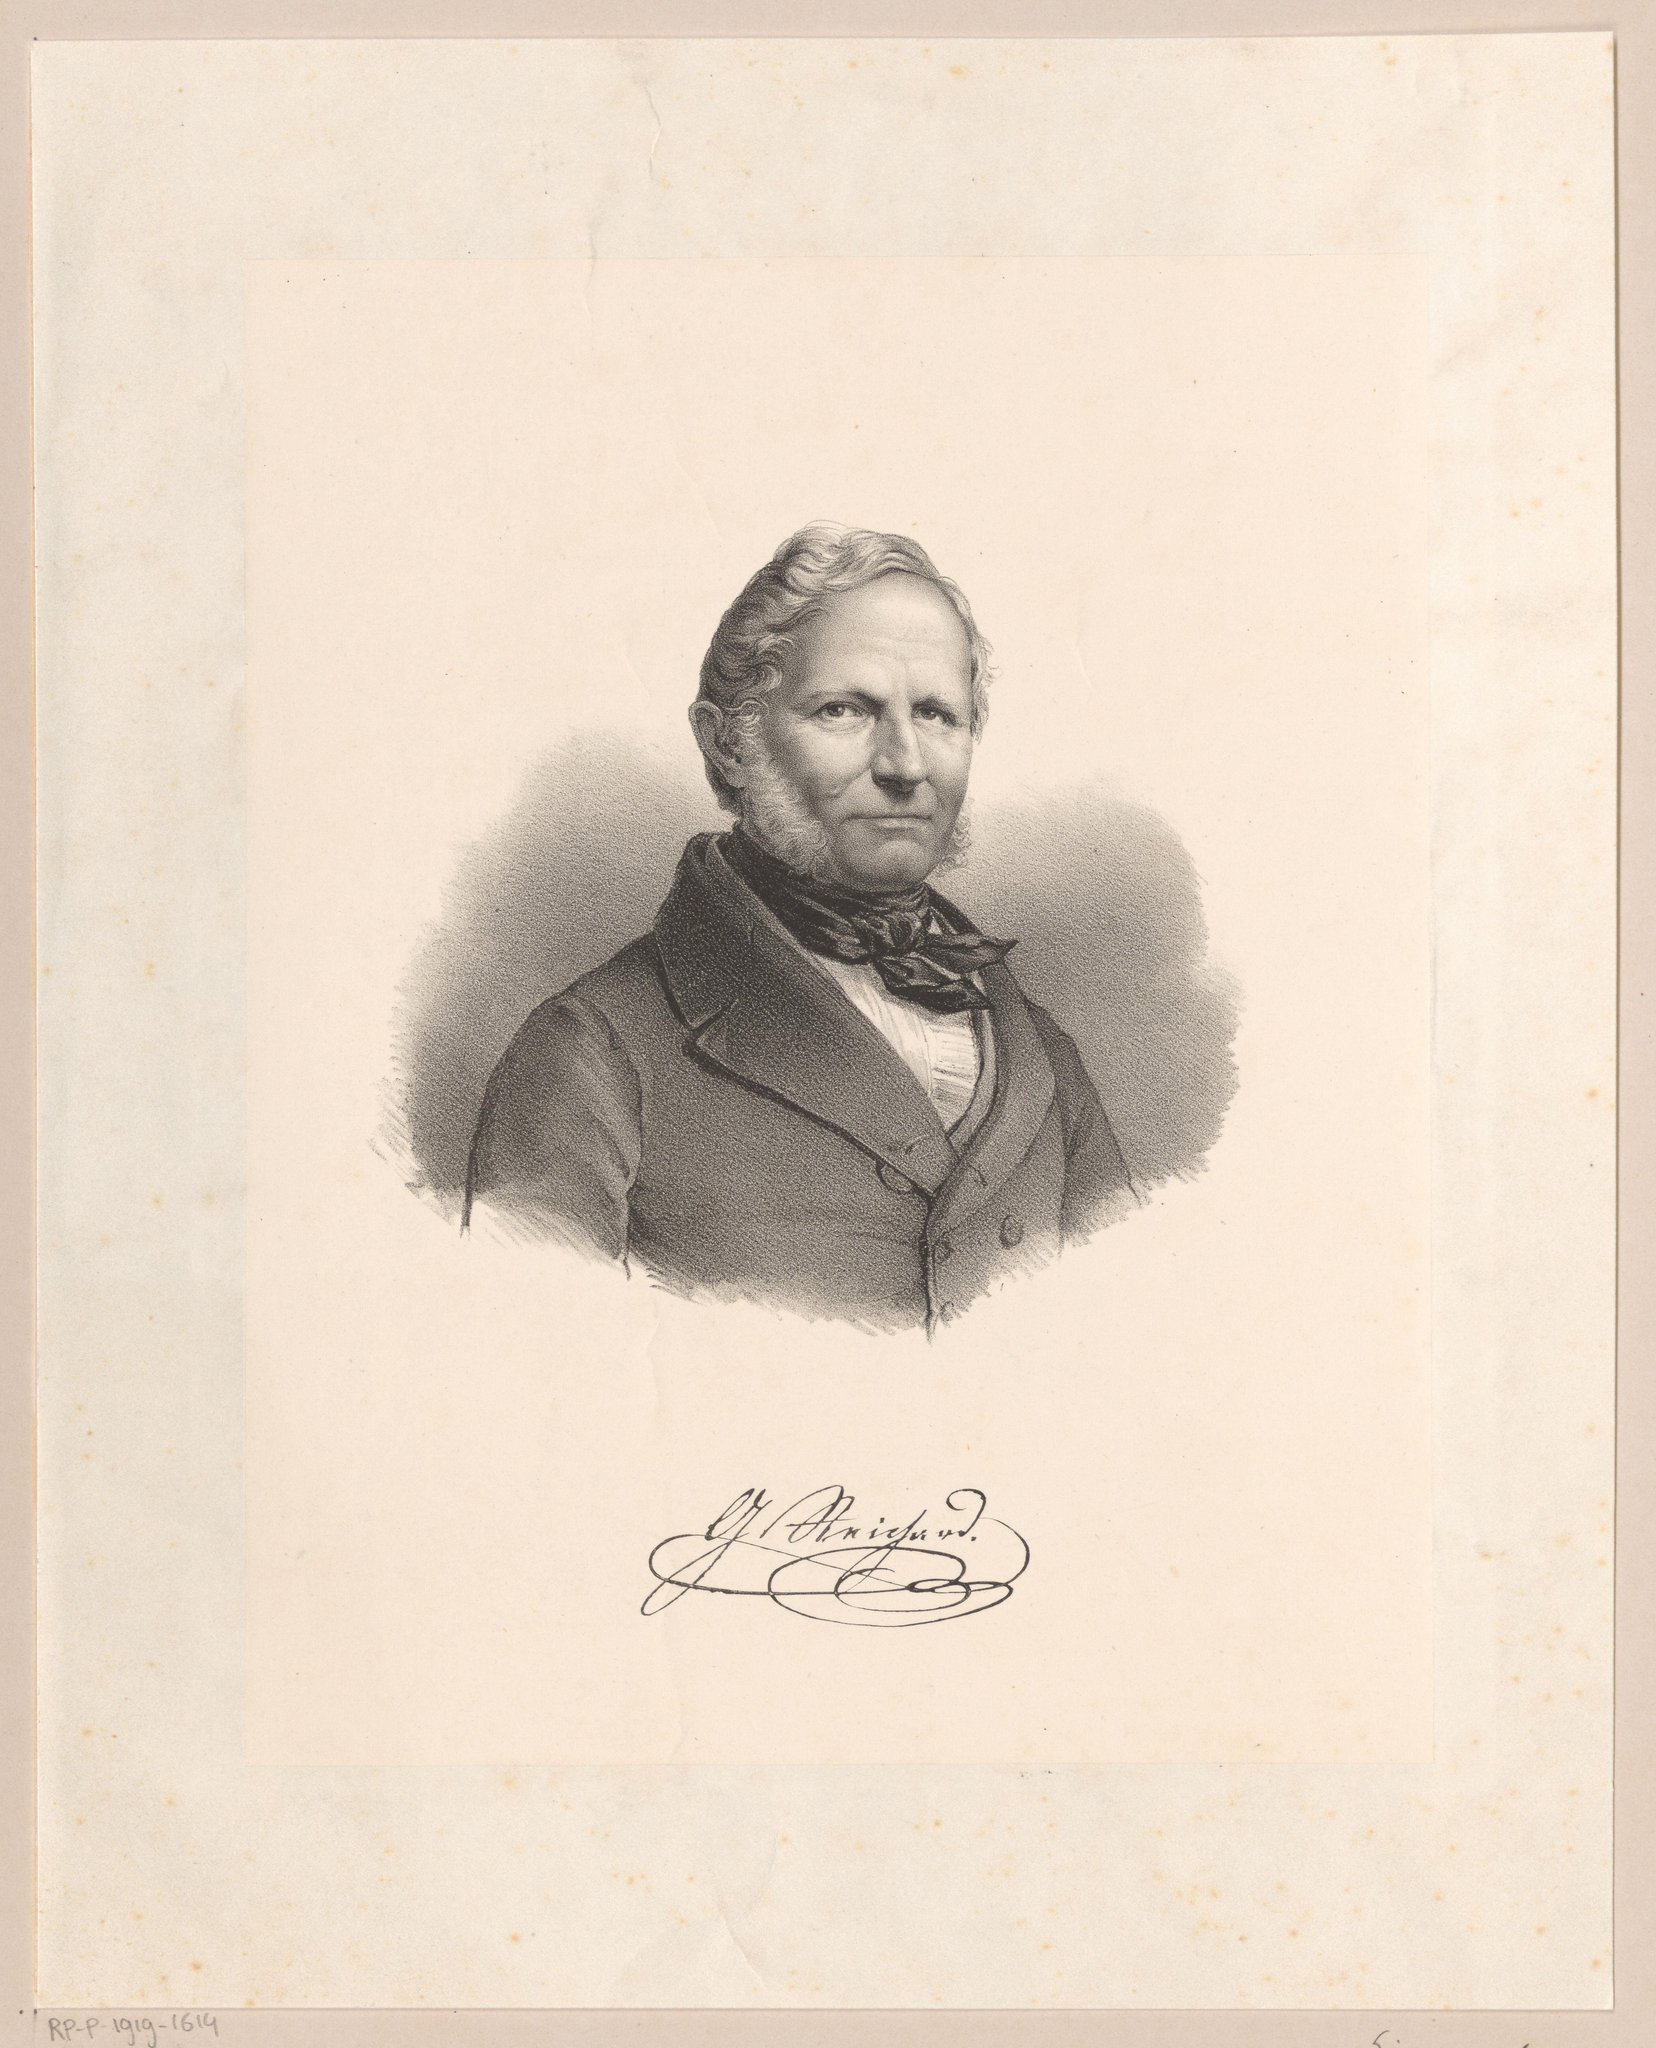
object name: print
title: Portret van G. Reichard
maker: Anonymous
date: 1795-1899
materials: paper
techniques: lithograph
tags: historical persons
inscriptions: collector's mark: Lugt 2228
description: Onder het portret een facsimile van de handtekening van de geportretteerde.